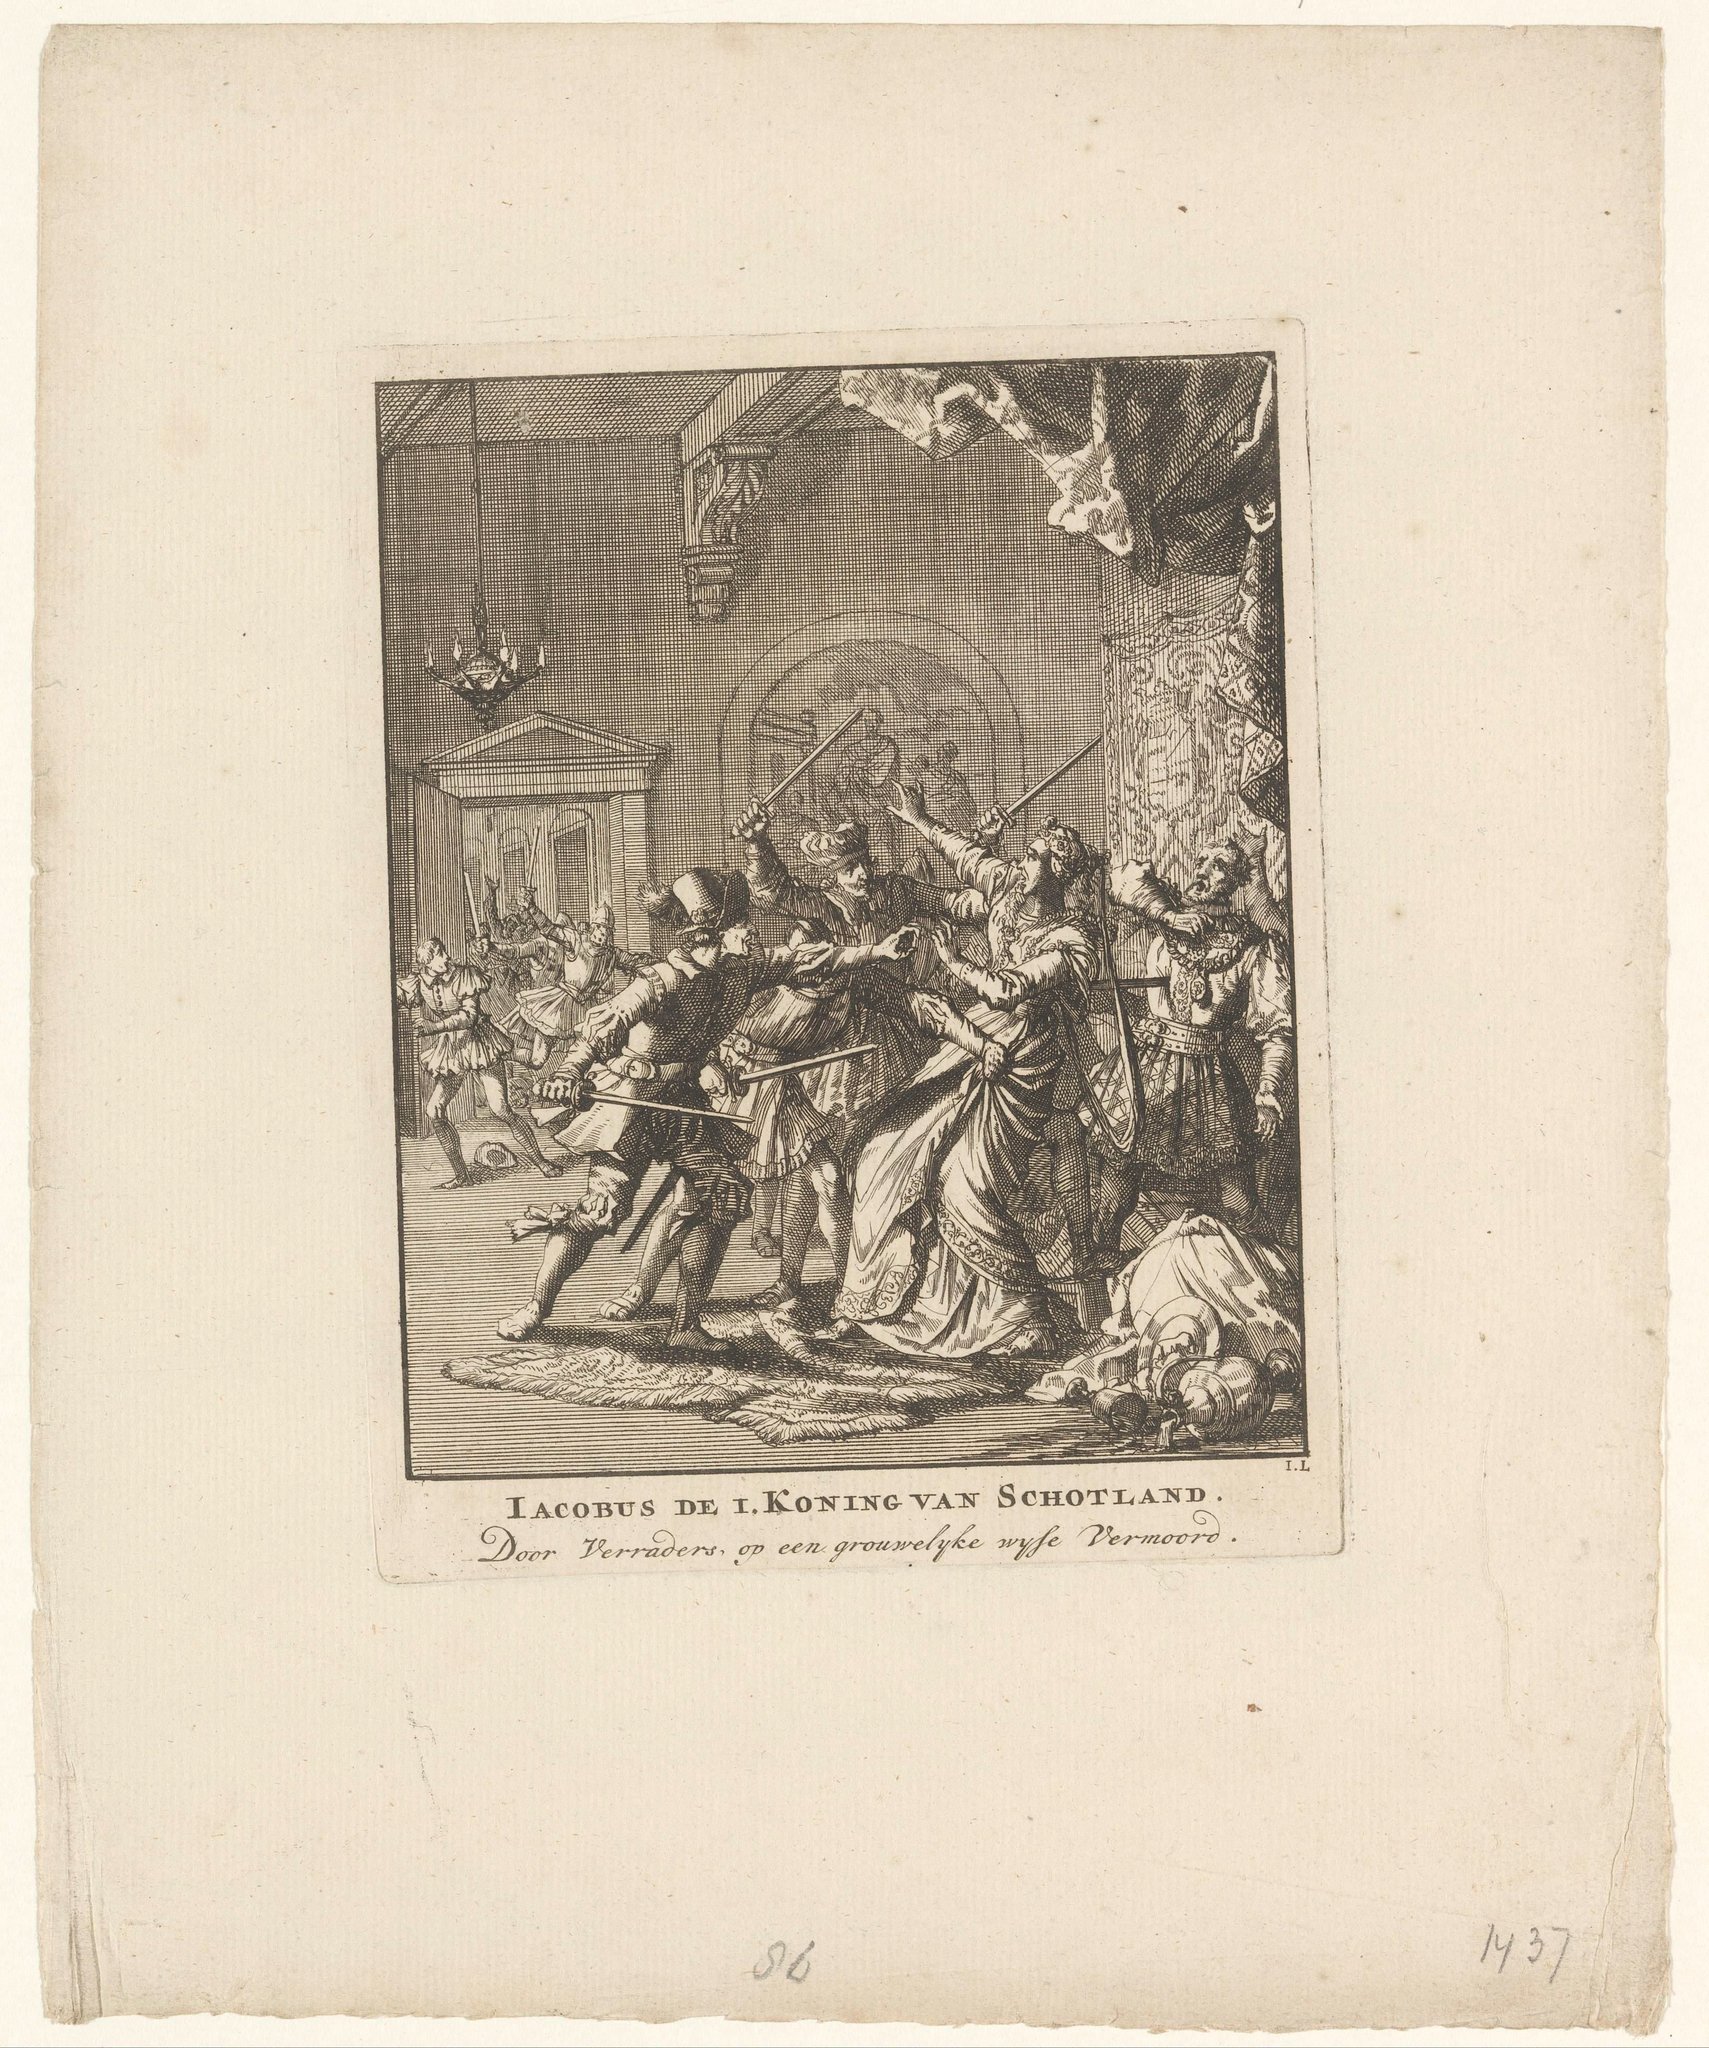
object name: print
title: Johannes van Capestrano roept de inwoners van Neurenberg op om spellen en speelkaarten te verbranden, 1452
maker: hans schäufelein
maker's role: print maker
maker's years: 1480-1540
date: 1500-1540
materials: paper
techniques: woodcut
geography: germany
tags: st. john of capestrano preaching against the vanities of this world; wordly goods are burned in public, backgammon, tric-trac, playing-cards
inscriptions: collector's mark: Lugt 240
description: De Franciscaanse minderbroeder Johannes van Capestrano roept de inwoners van Neurenberg op om wereldse vermaak zoals bordspellen en speelkaarten te verbranden, 1452.